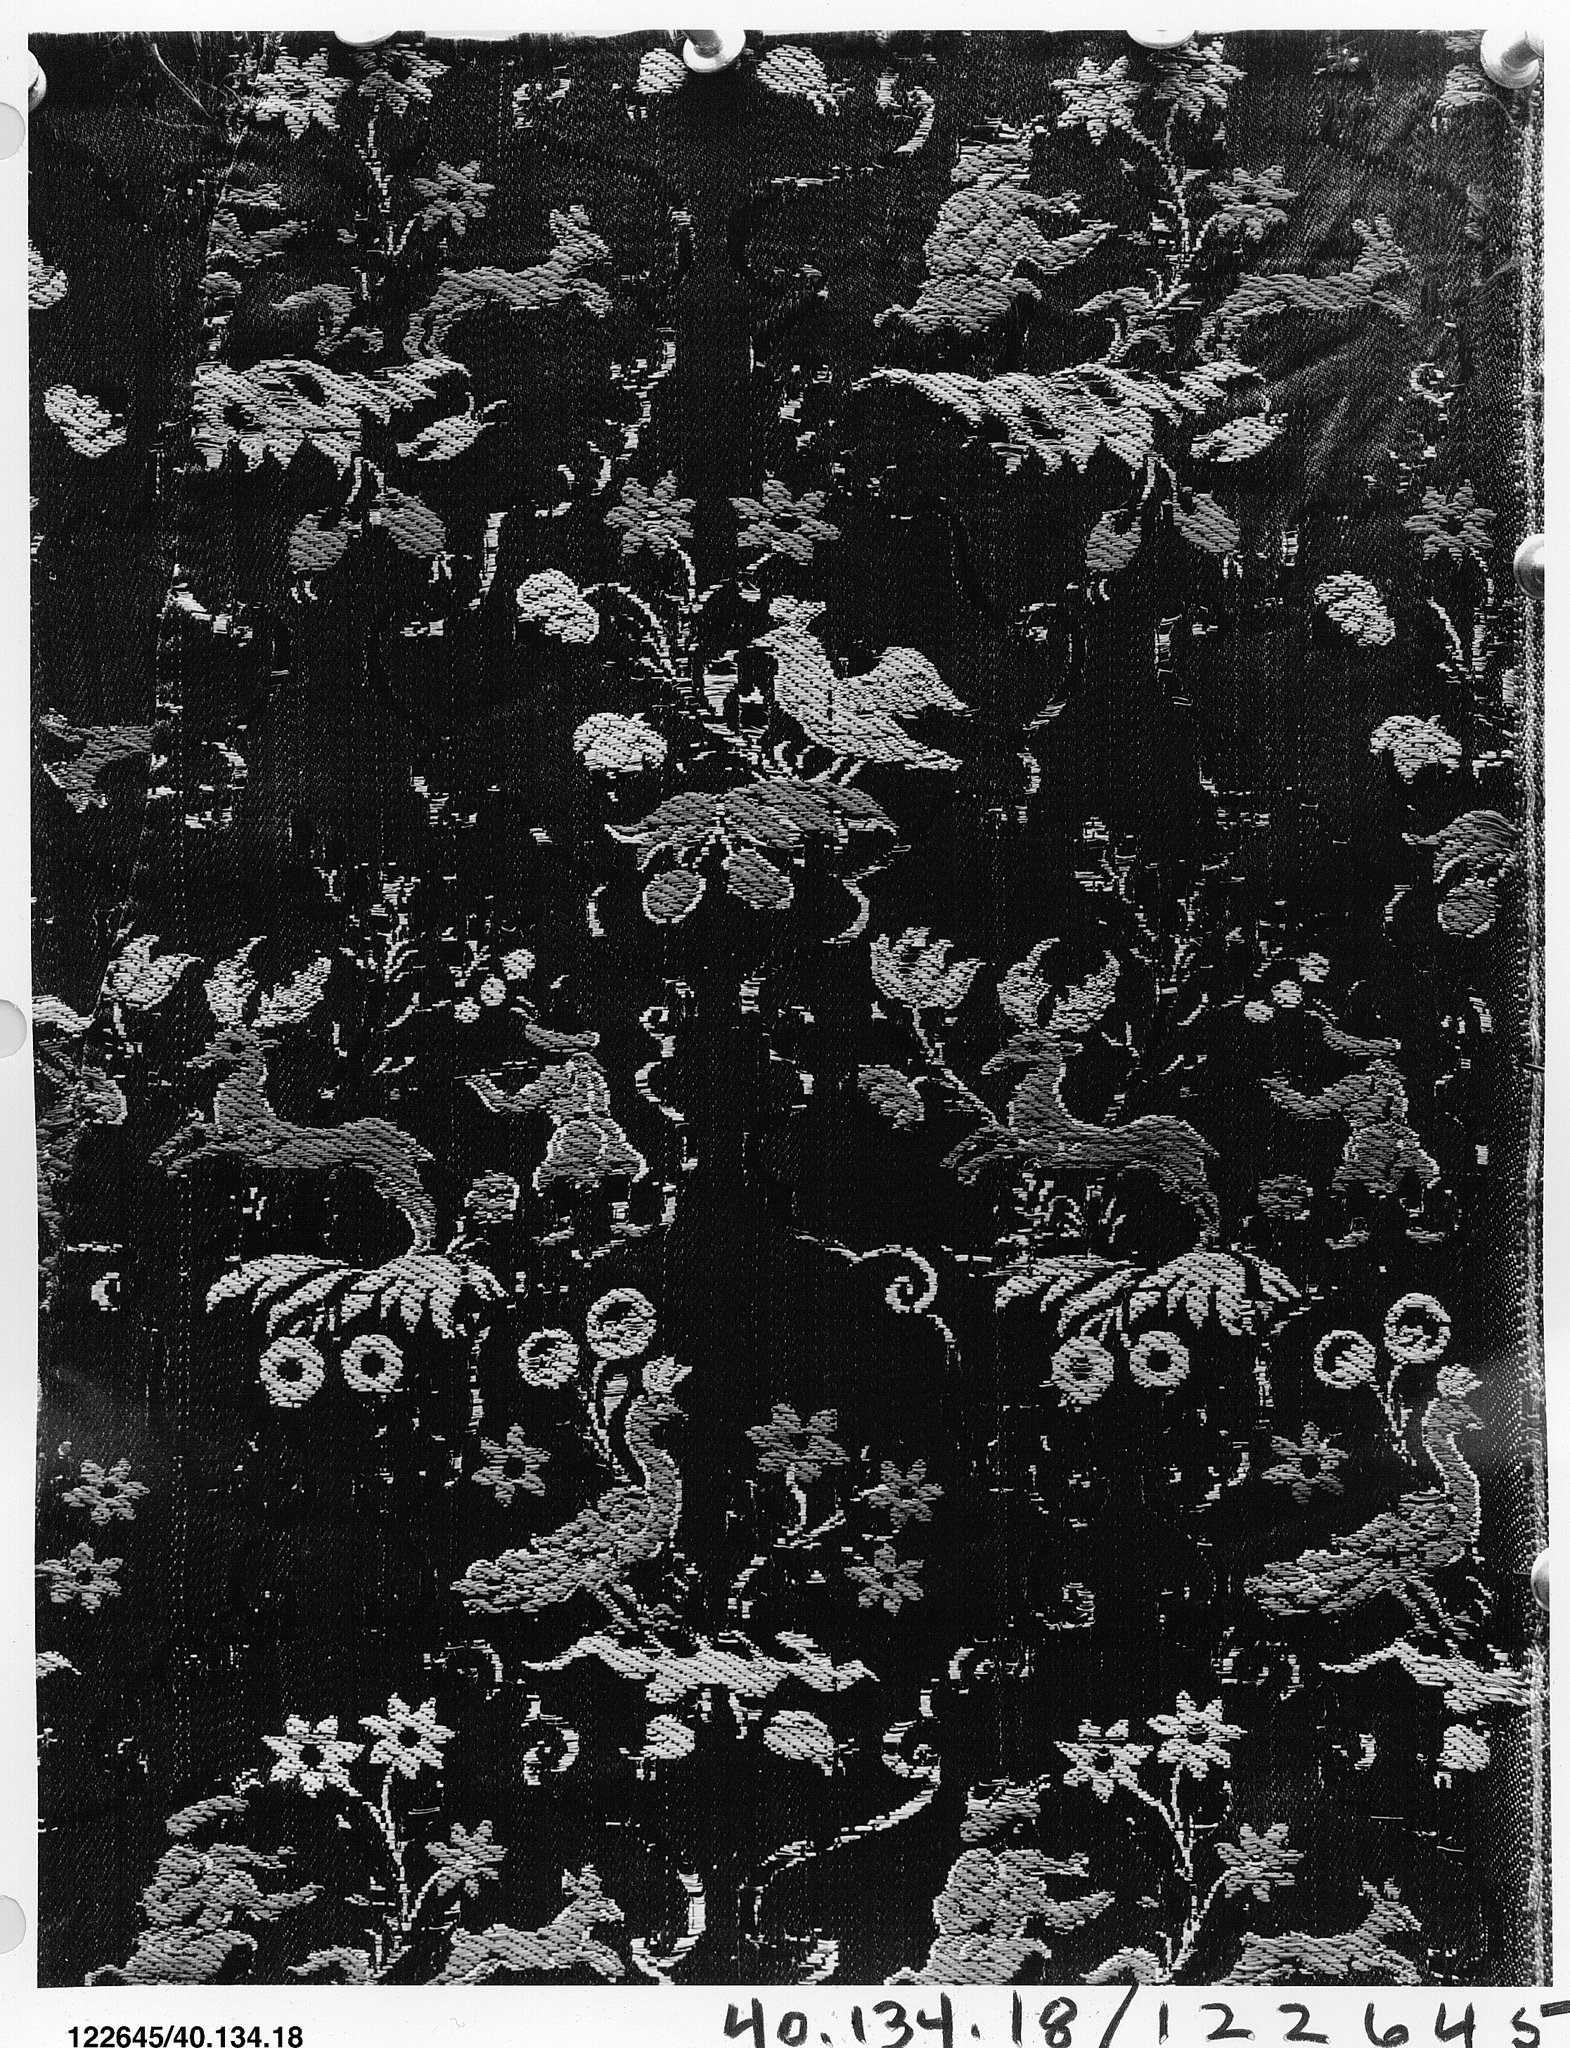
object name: piece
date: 1734-1766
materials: silk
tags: birds,men,hunting,deer